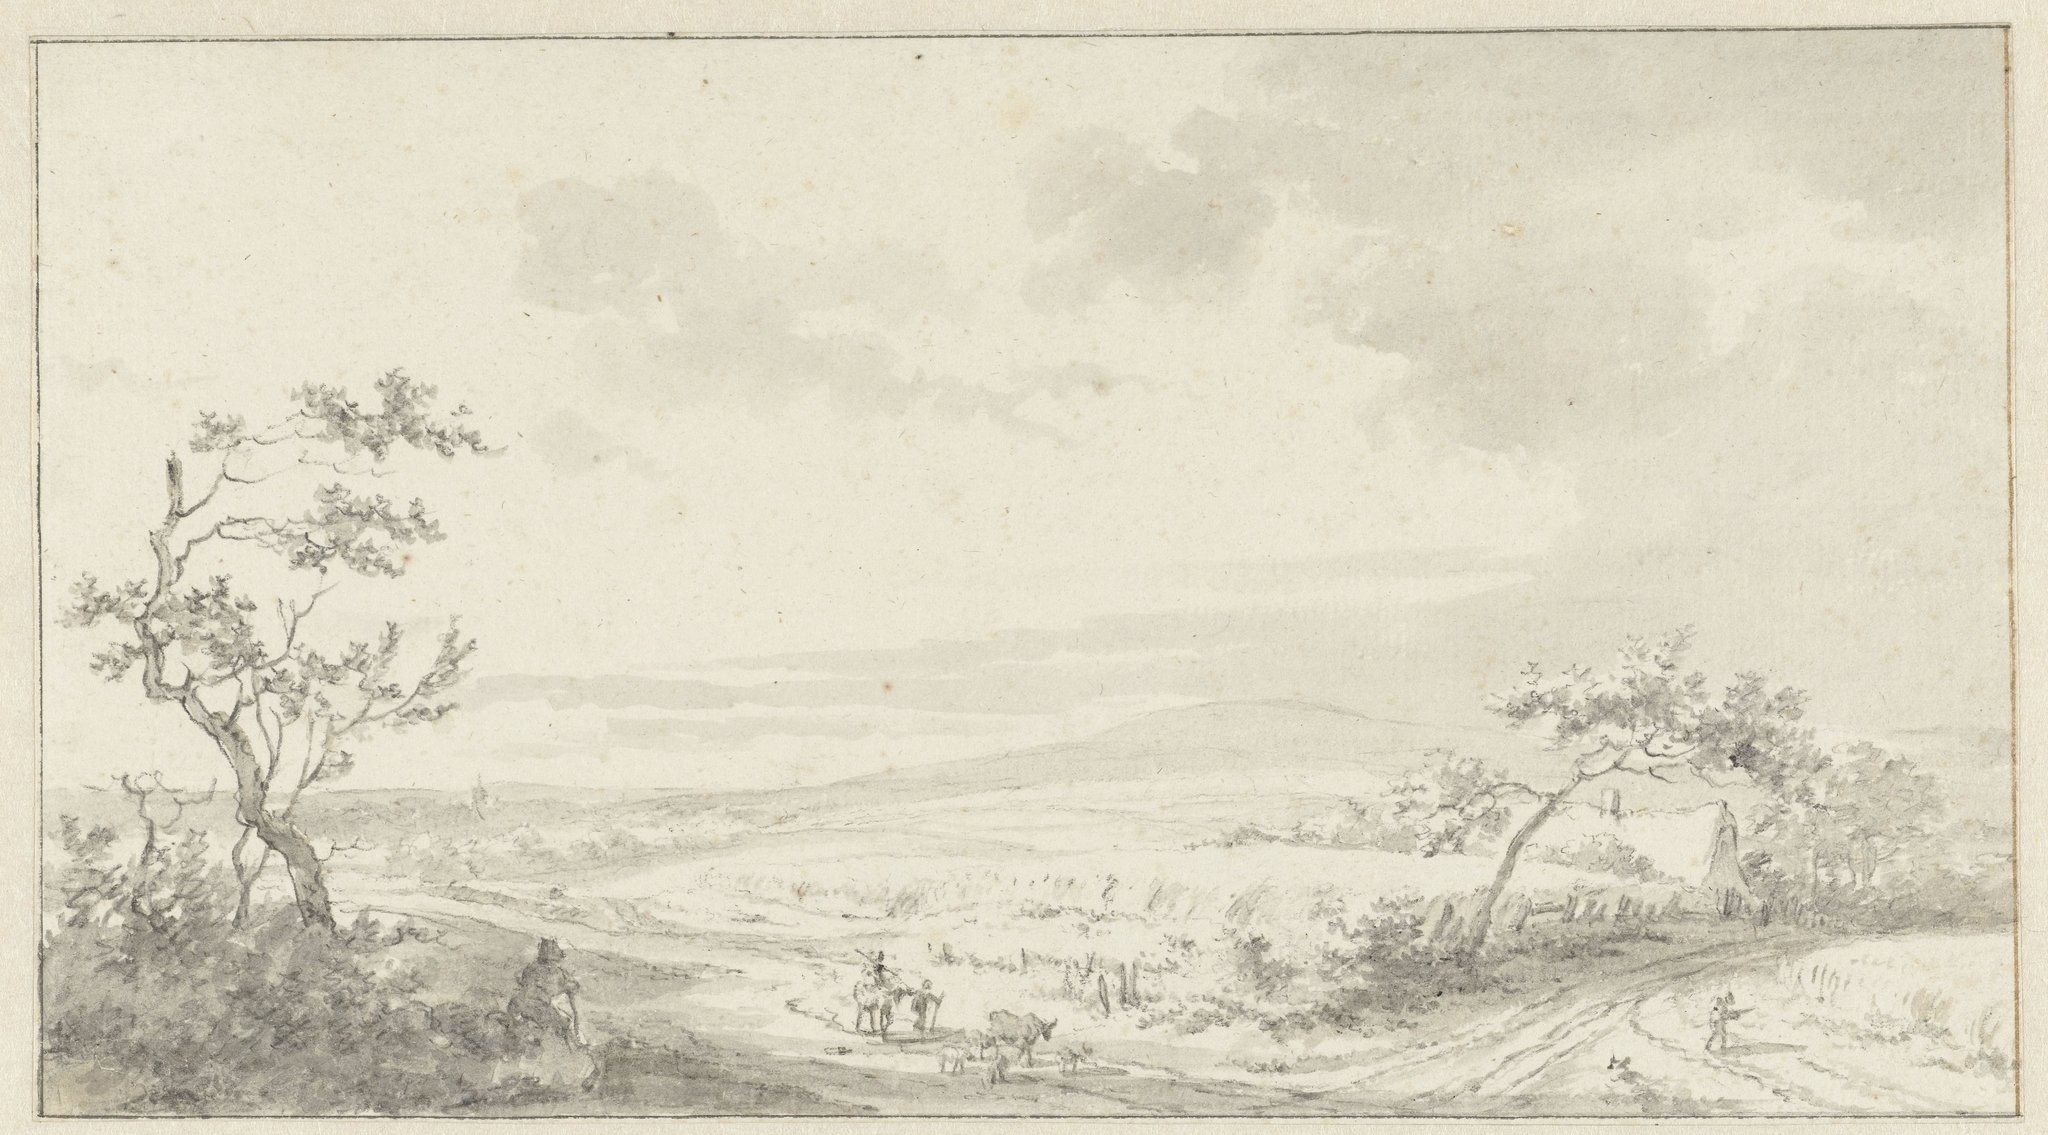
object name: drawing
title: Uitgestrekt landschap met landweg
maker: jacob cats (1741-1799)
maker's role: draughtsman, print maker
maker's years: 1741-1799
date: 1751-1799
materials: chalk, paper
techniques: brush